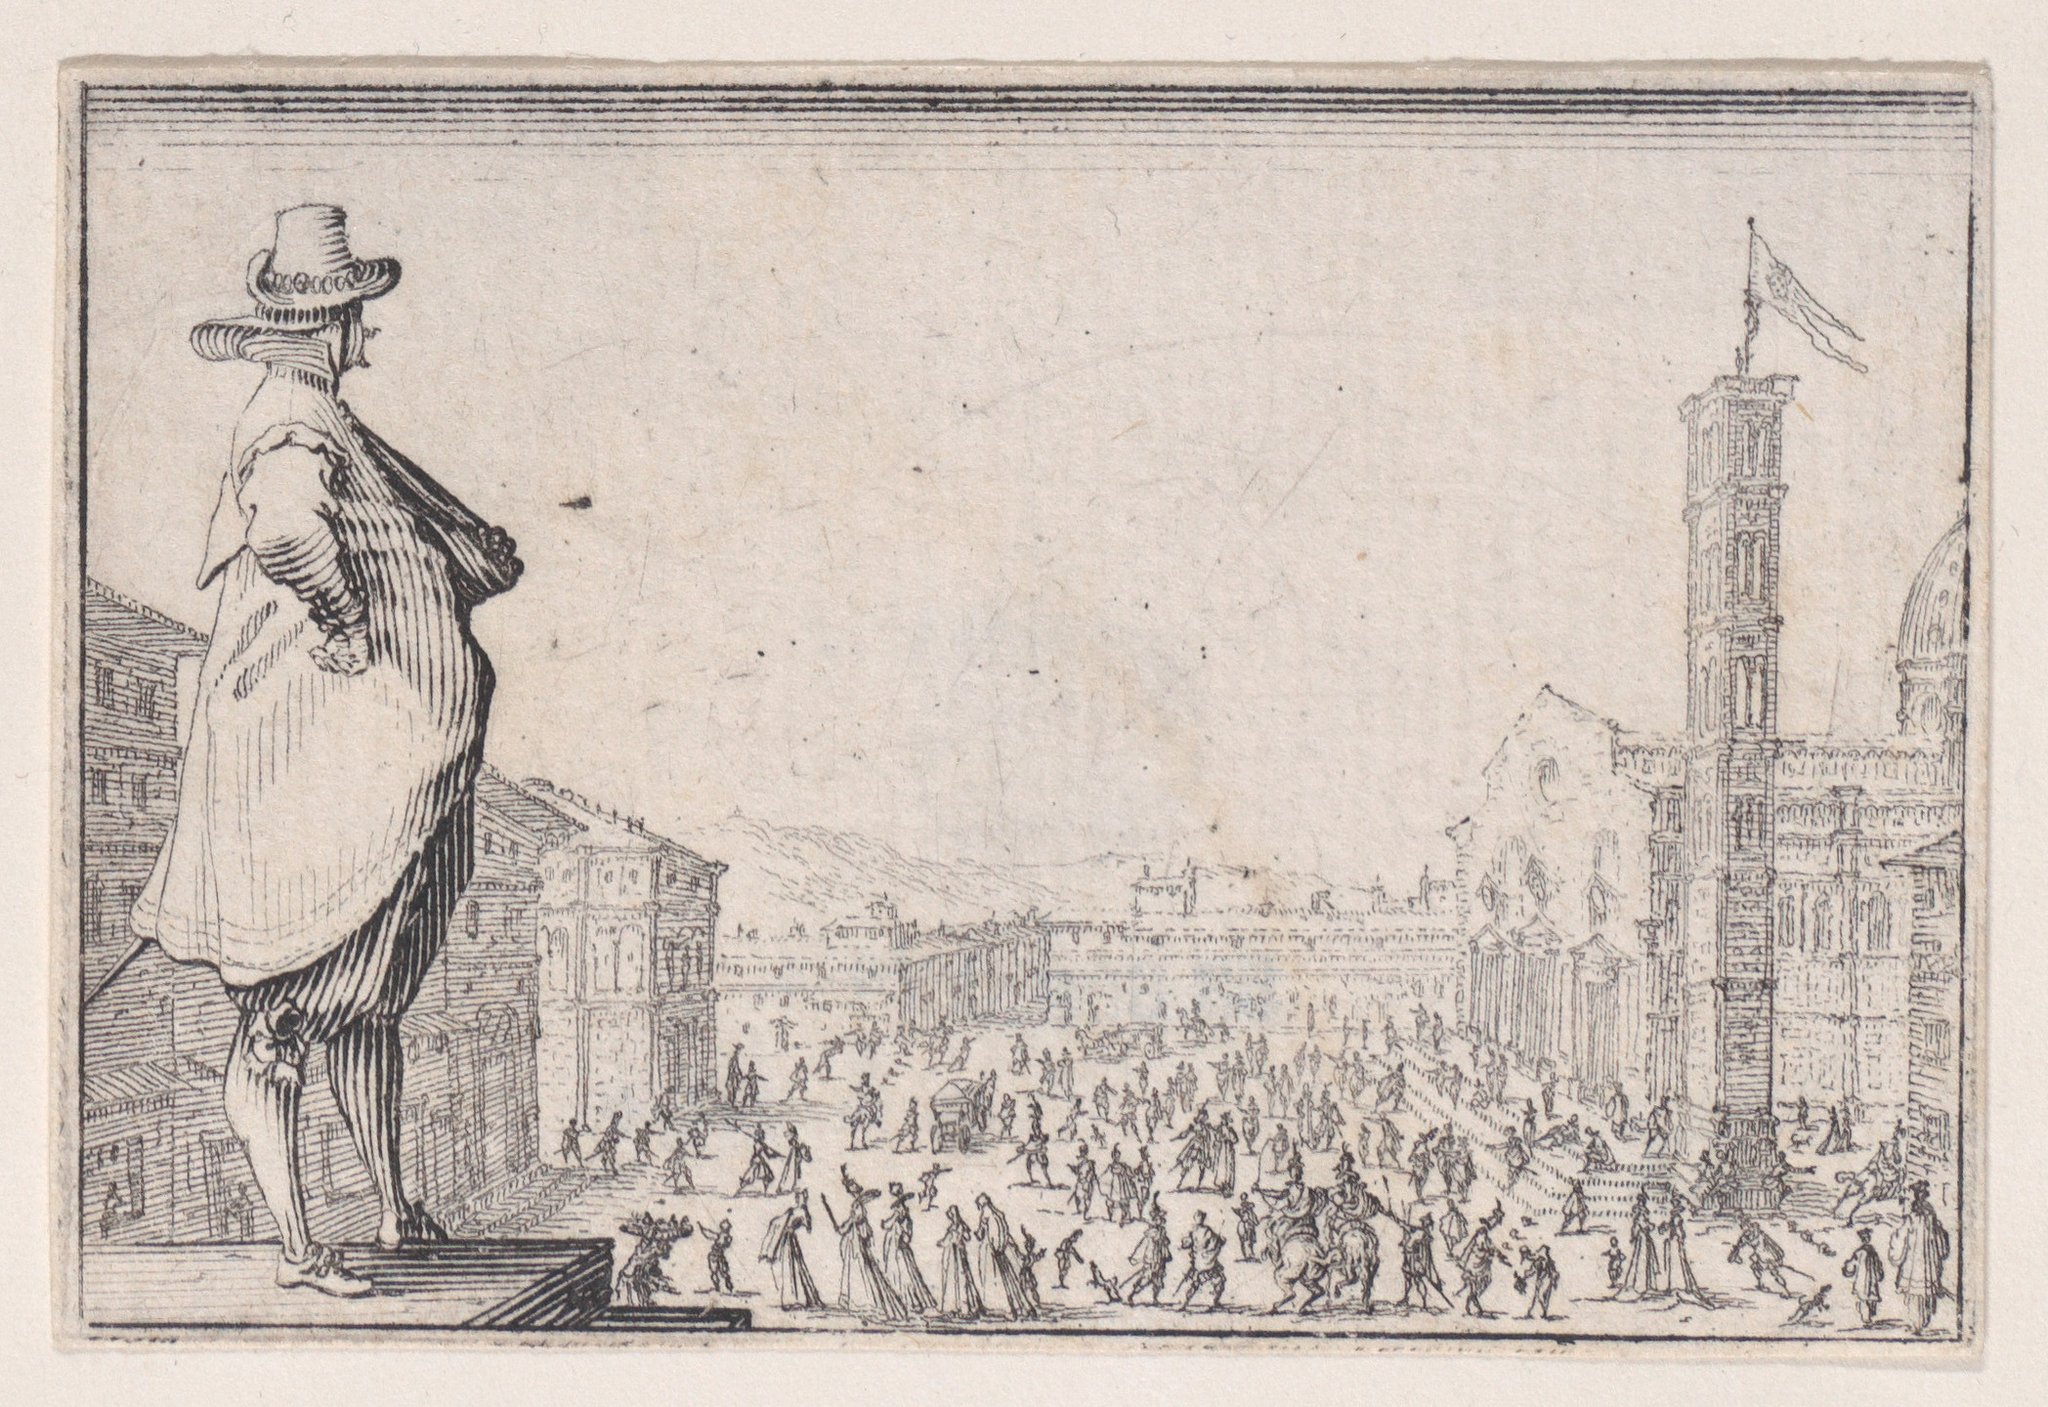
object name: print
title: La Place du Dome a Florence (Piazza del Duomo in Florence), from Les Caprices Series A, The Florence Set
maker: jacques callot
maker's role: artist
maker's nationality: french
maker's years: 1592-1635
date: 1617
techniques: etching